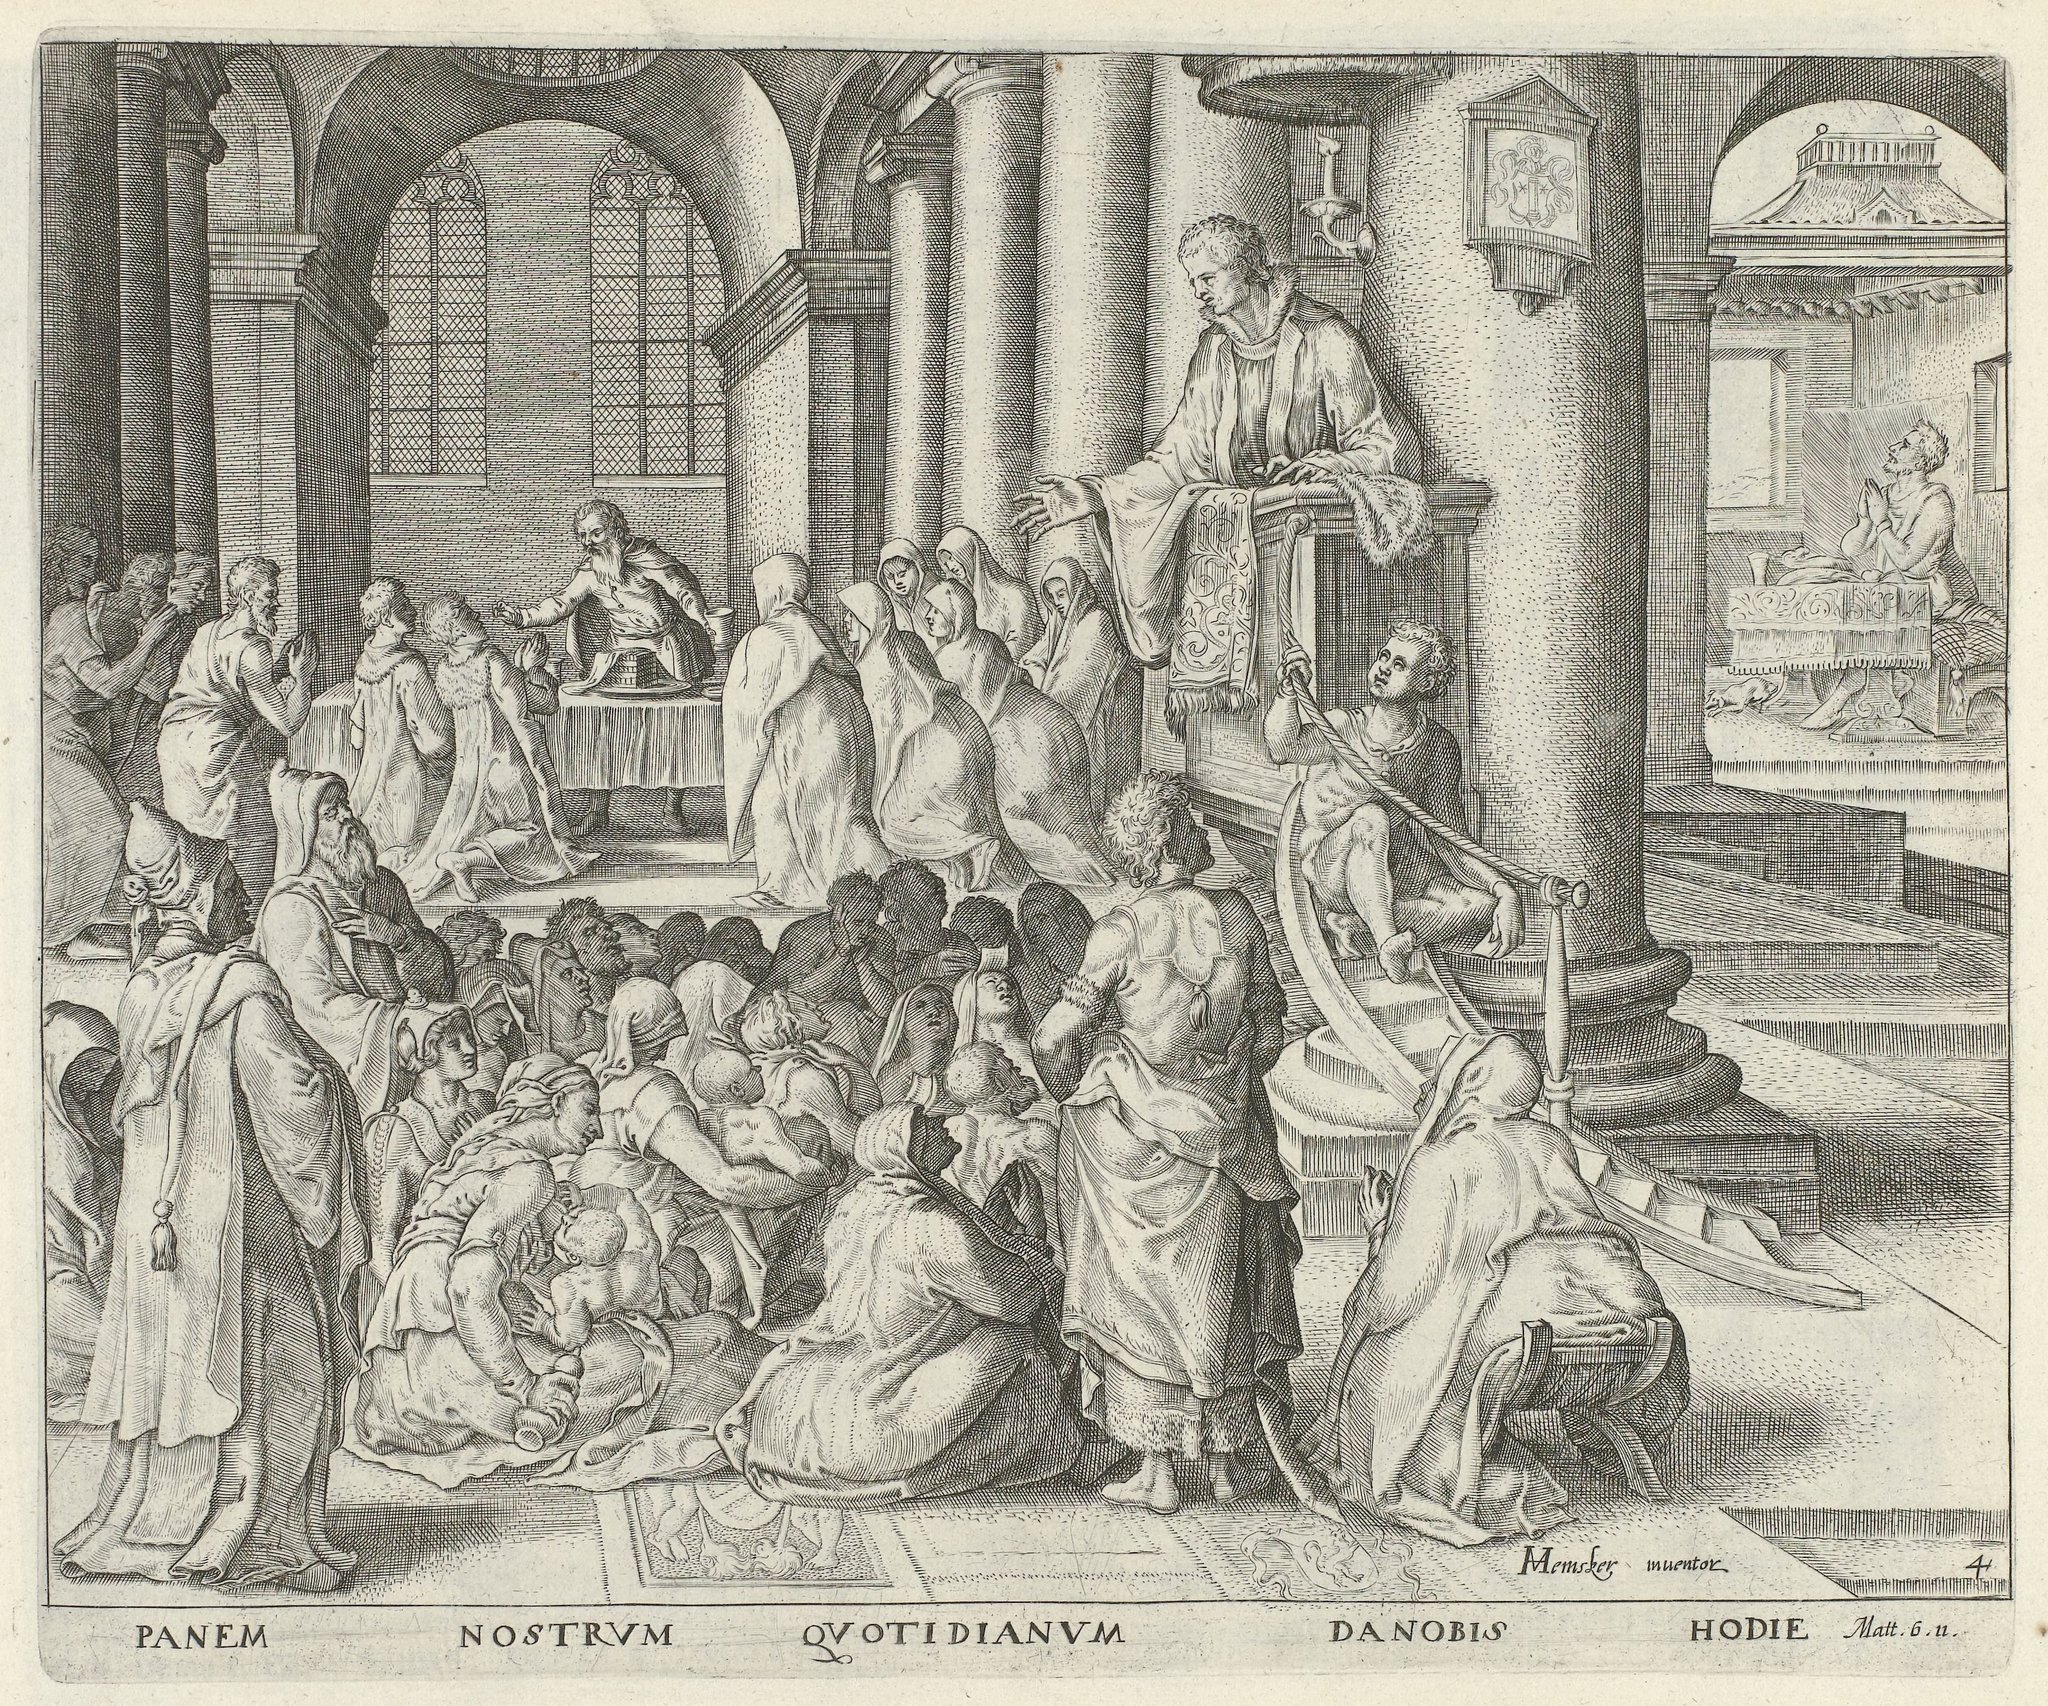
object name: print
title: Geef ons vandaag het brood dat wij nodig hebben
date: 1569-1573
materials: paper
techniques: engraving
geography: amsterdam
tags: the lord's prayer (matthew 6:9-13; luke 11:2-4), holy communion ~ protestant service, sermon ~ protestant service, 'give us this day our daily bread' ~ the lord's prayer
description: Gezicht in een protestantse kerk. Op de voorgrond een predikant op de preekstoel, prekend voor een groep geknielde gelovigen voor hem. Op de achtergrond het avondmaal zoals gevierd bij de protestanten. Rechts een vertrek waarin een man bidt voor zijn maaltijd. Illustratie van een regel van het Onze Vader gebed: Geef ons vandaag het brood dat wij nodig hebben. Onder de voorstelling dit gedeelte van het Onze Vader in het Latijn en een verwijzing naar de Bijbeltekst in Mat. 6:11. Deze prent maakt deel uit van een album.